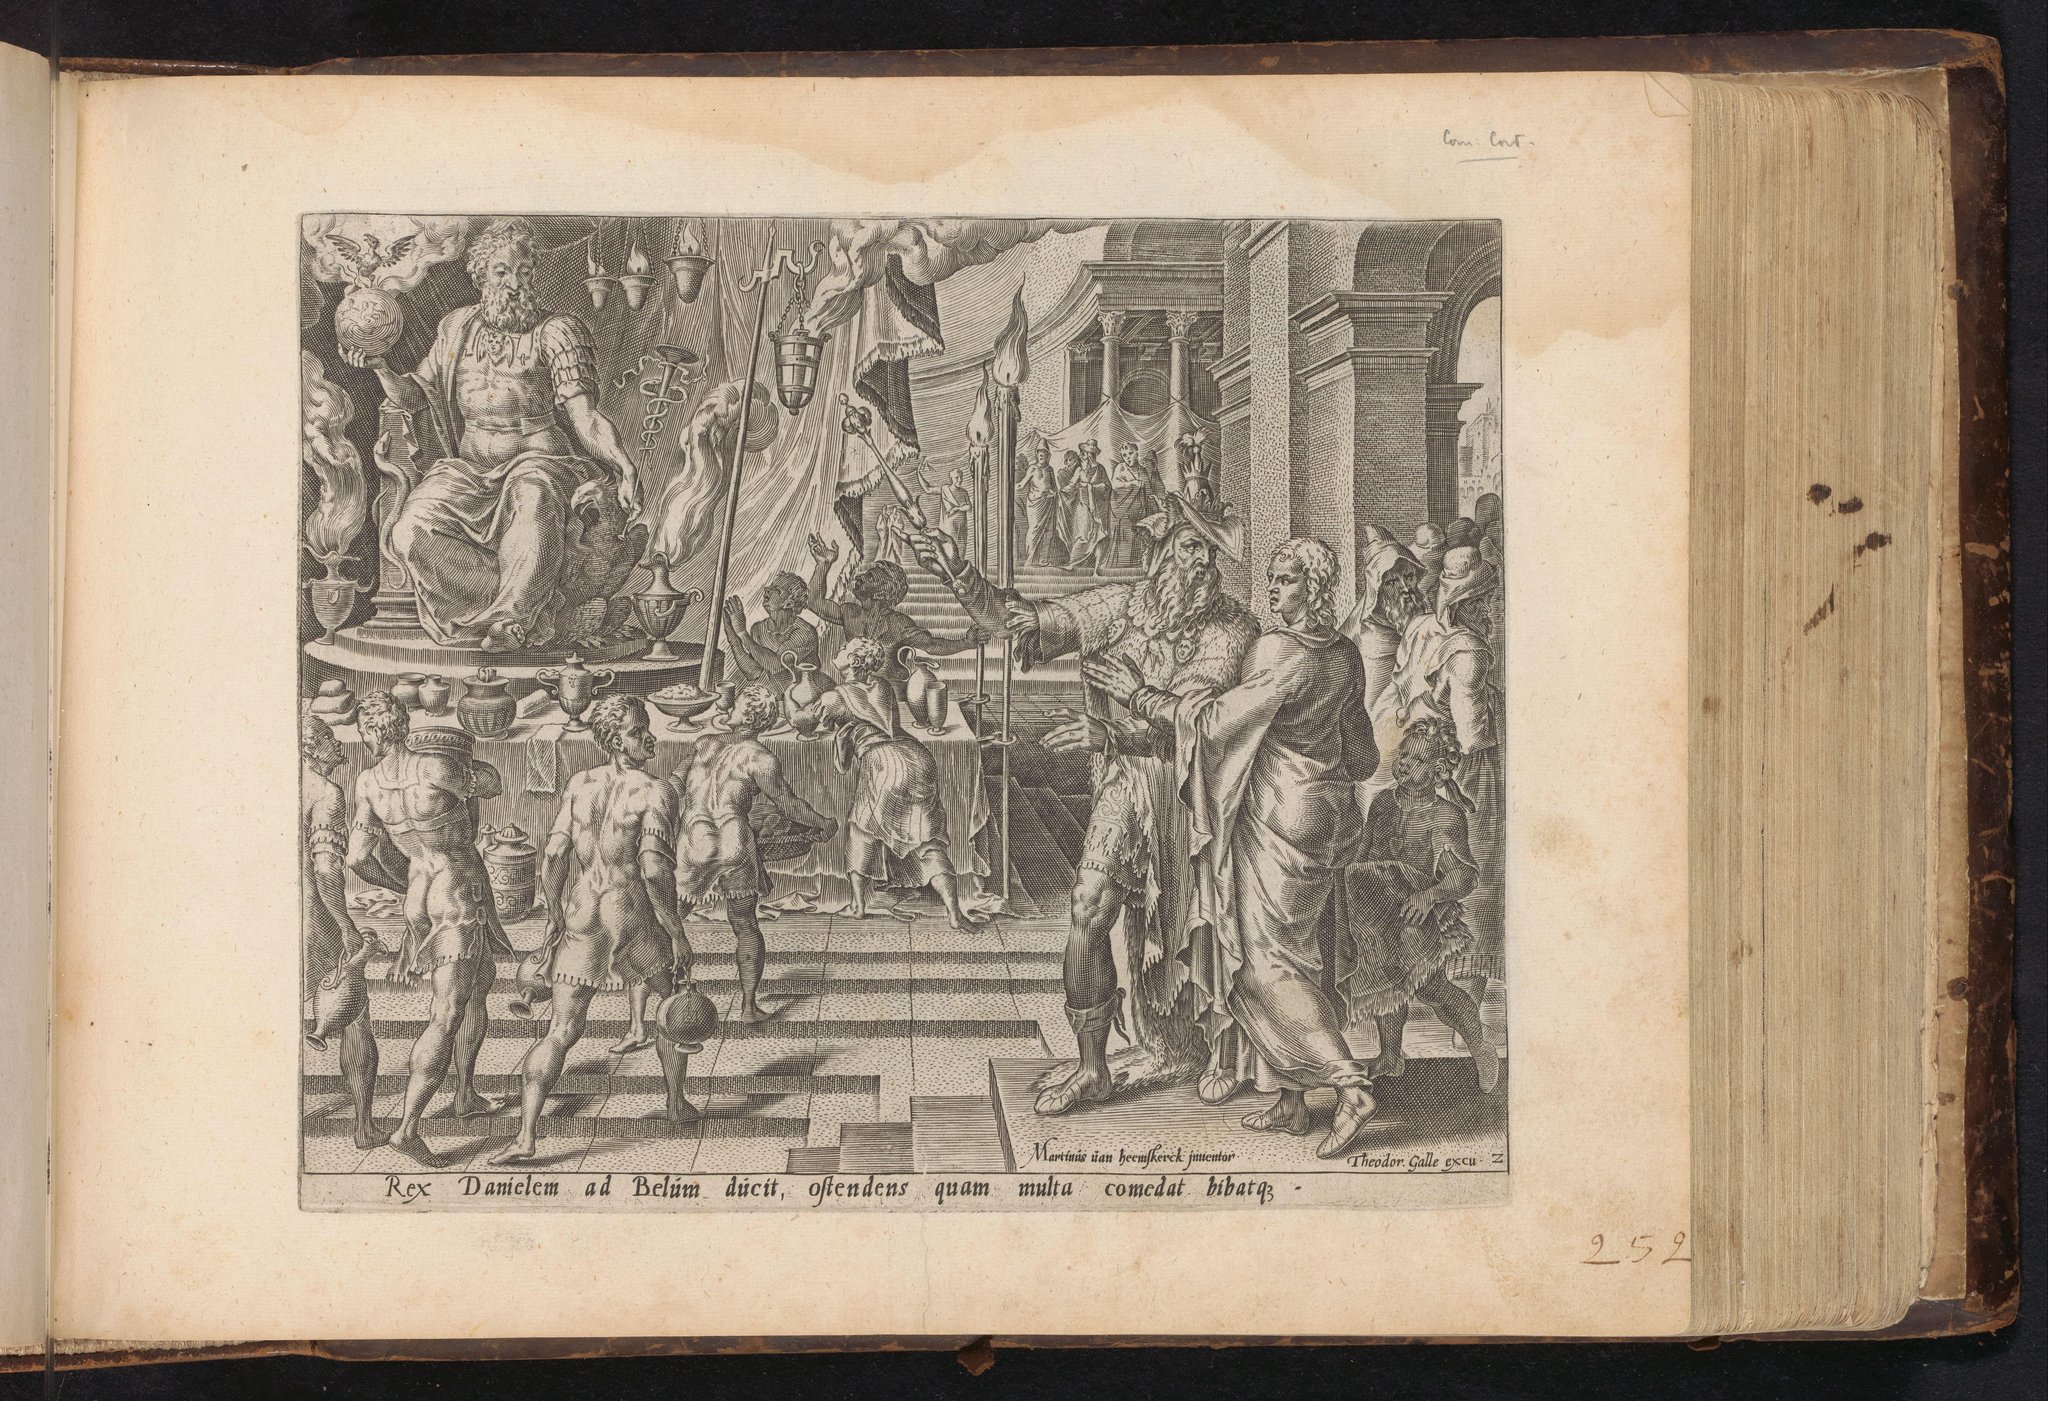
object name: album leaf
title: Den Grooten Figuer-Bibel (...)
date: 1565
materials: paper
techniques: engraving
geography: alkmaar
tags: king cyrus sets food before the image of bel; daniel and his servants strew ashes on the floor of the temple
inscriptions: number: ‘252’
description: Koning Cyrus toont Daniël de tempel van de god Bel. In het midden van de tempel staat een groot beeld van de zittende godheid. Eromheen staan vazen met reukwerk. Dienaren zijn bezig om op een tafel voor het beeld eten en drinken uit te stallen. Onder de voorstelling een verklarende tekst in het Latijn. Prent maakt deel uit van een album.